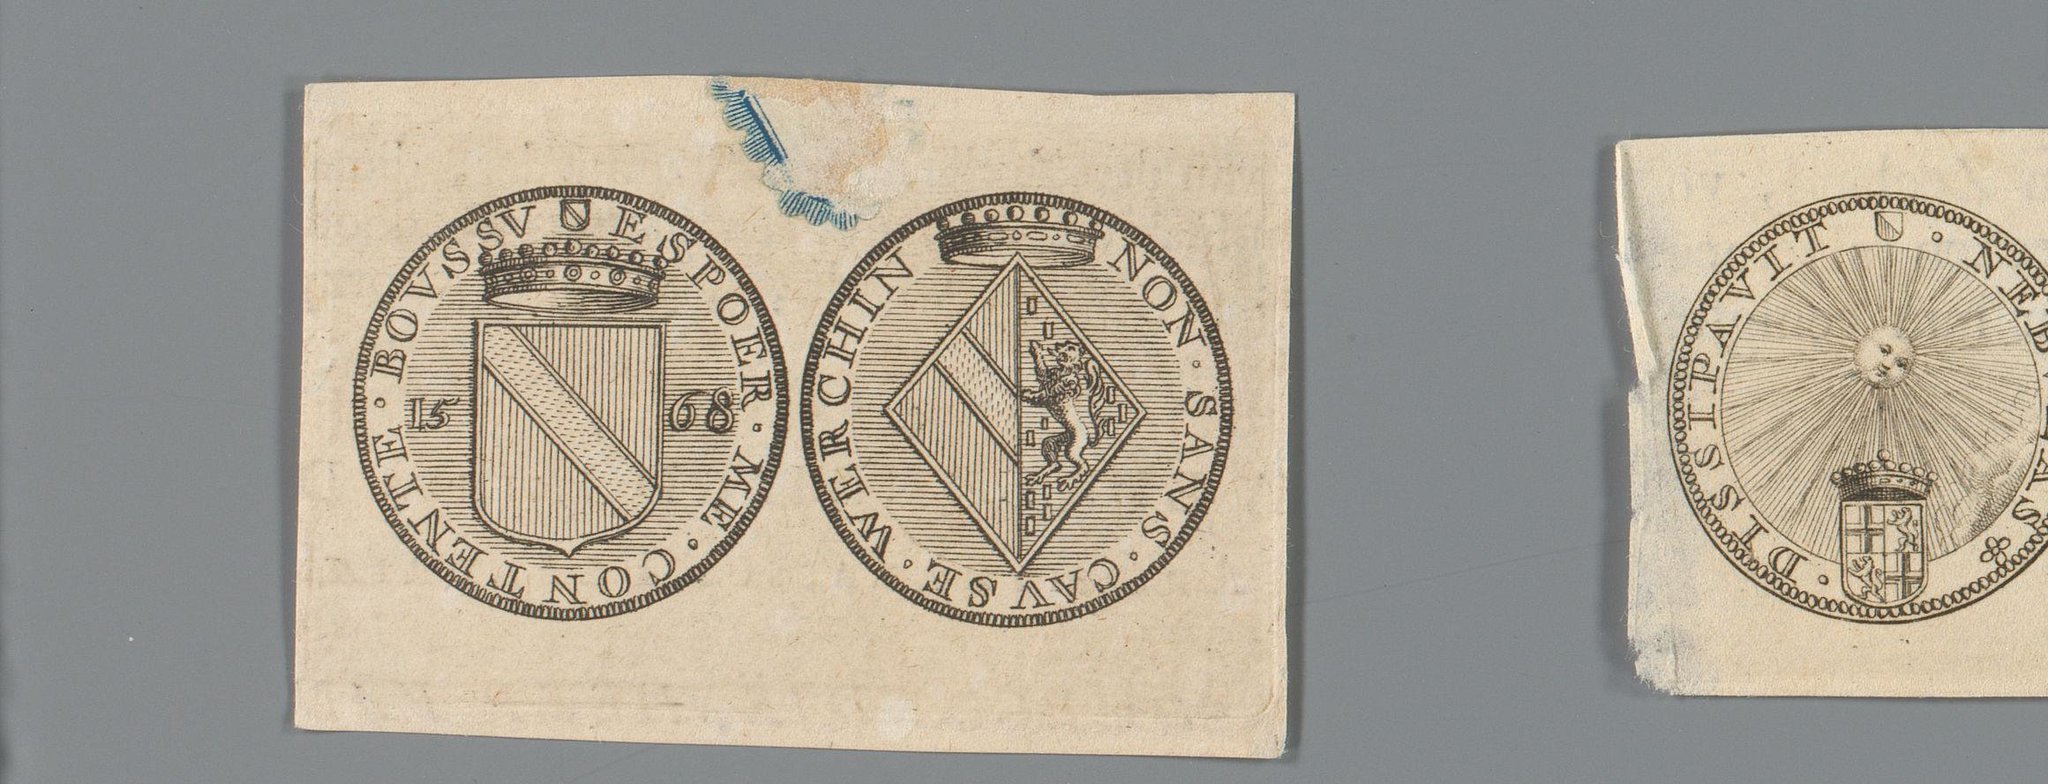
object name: book illustration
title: Voorzijde- en achterzijde van een penning met daarop het wapen van Maximiliaan, graaf van Hennin-Lietard en het wapen van Charlotte de Werchin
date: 1723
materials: paper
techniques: etching, letterpress printing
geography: the hague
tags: antwerp, coat of arms (symbol of sovereignty), historical persons - bb - woman, historical persons, coin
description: Prent uit: Loon, Gerard van. Beschryving der Nederlandsche Historipenningen: (...). Den Haag: Christiaan van Lom et al., 1723, dl. 1, p. 149.